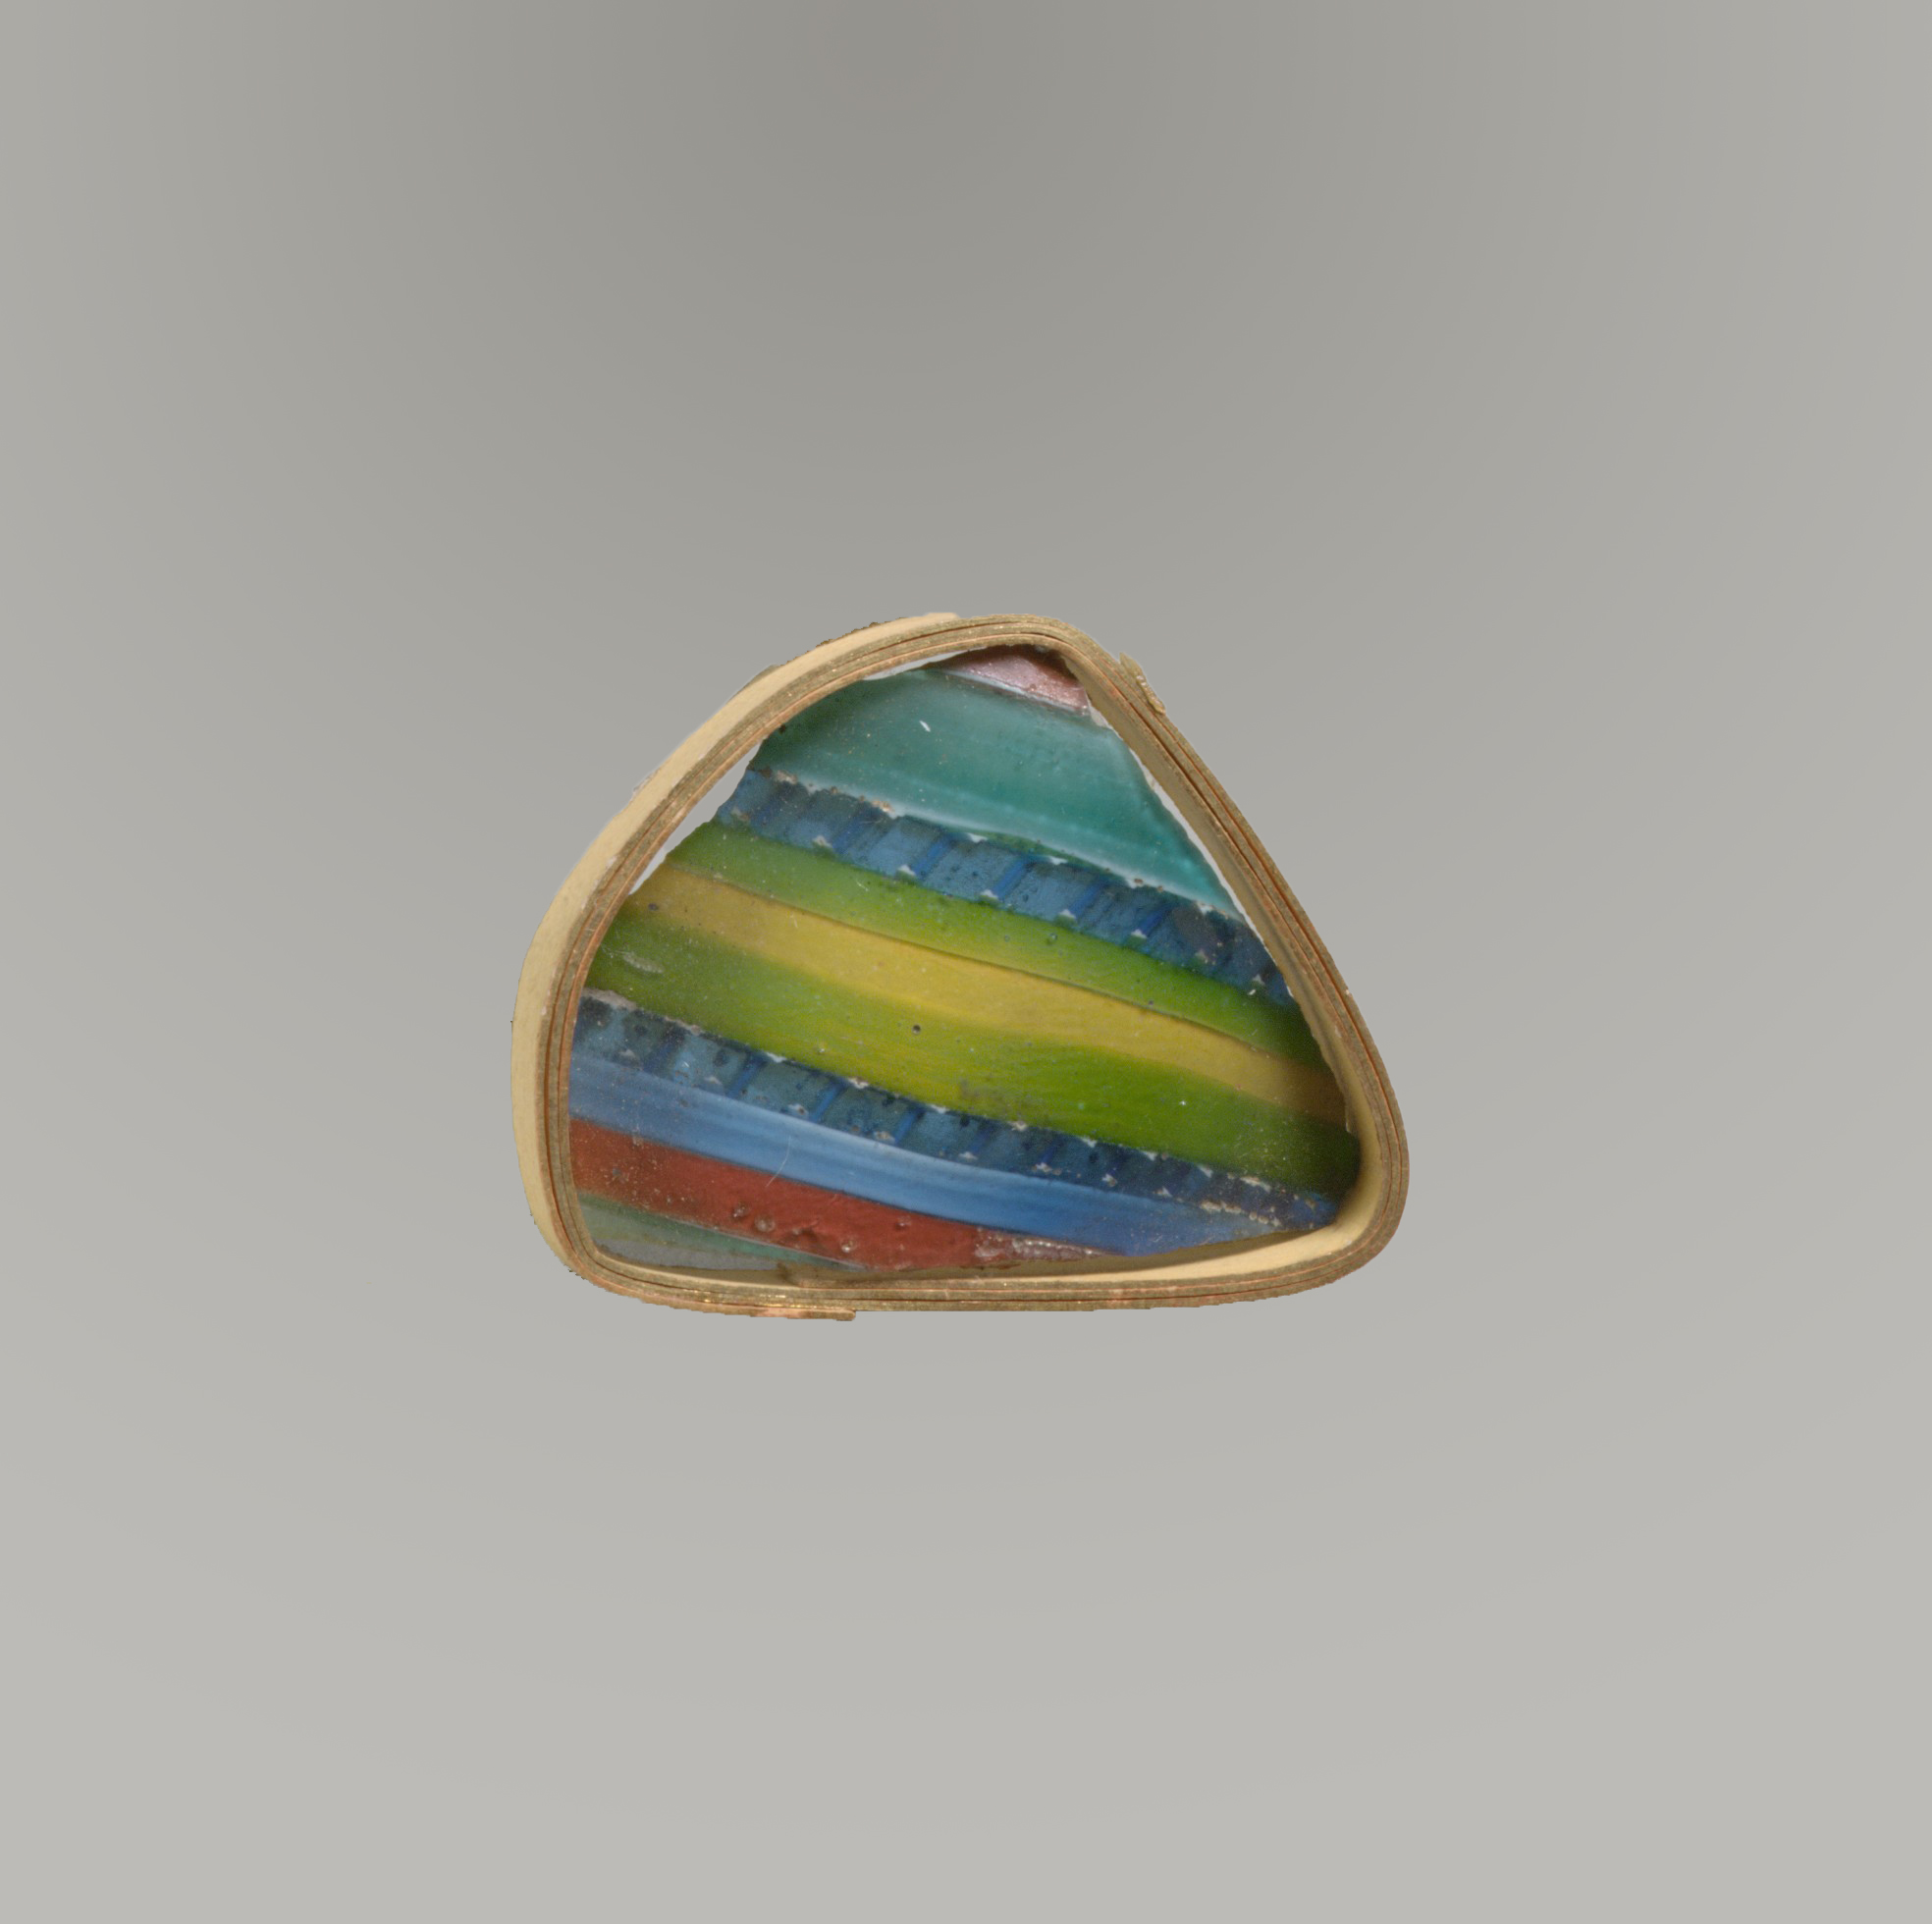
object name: fragment, striped mosaic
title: Glass striped mosaic bowl fragment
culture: roman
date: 34 BCE-33 CE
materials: glass